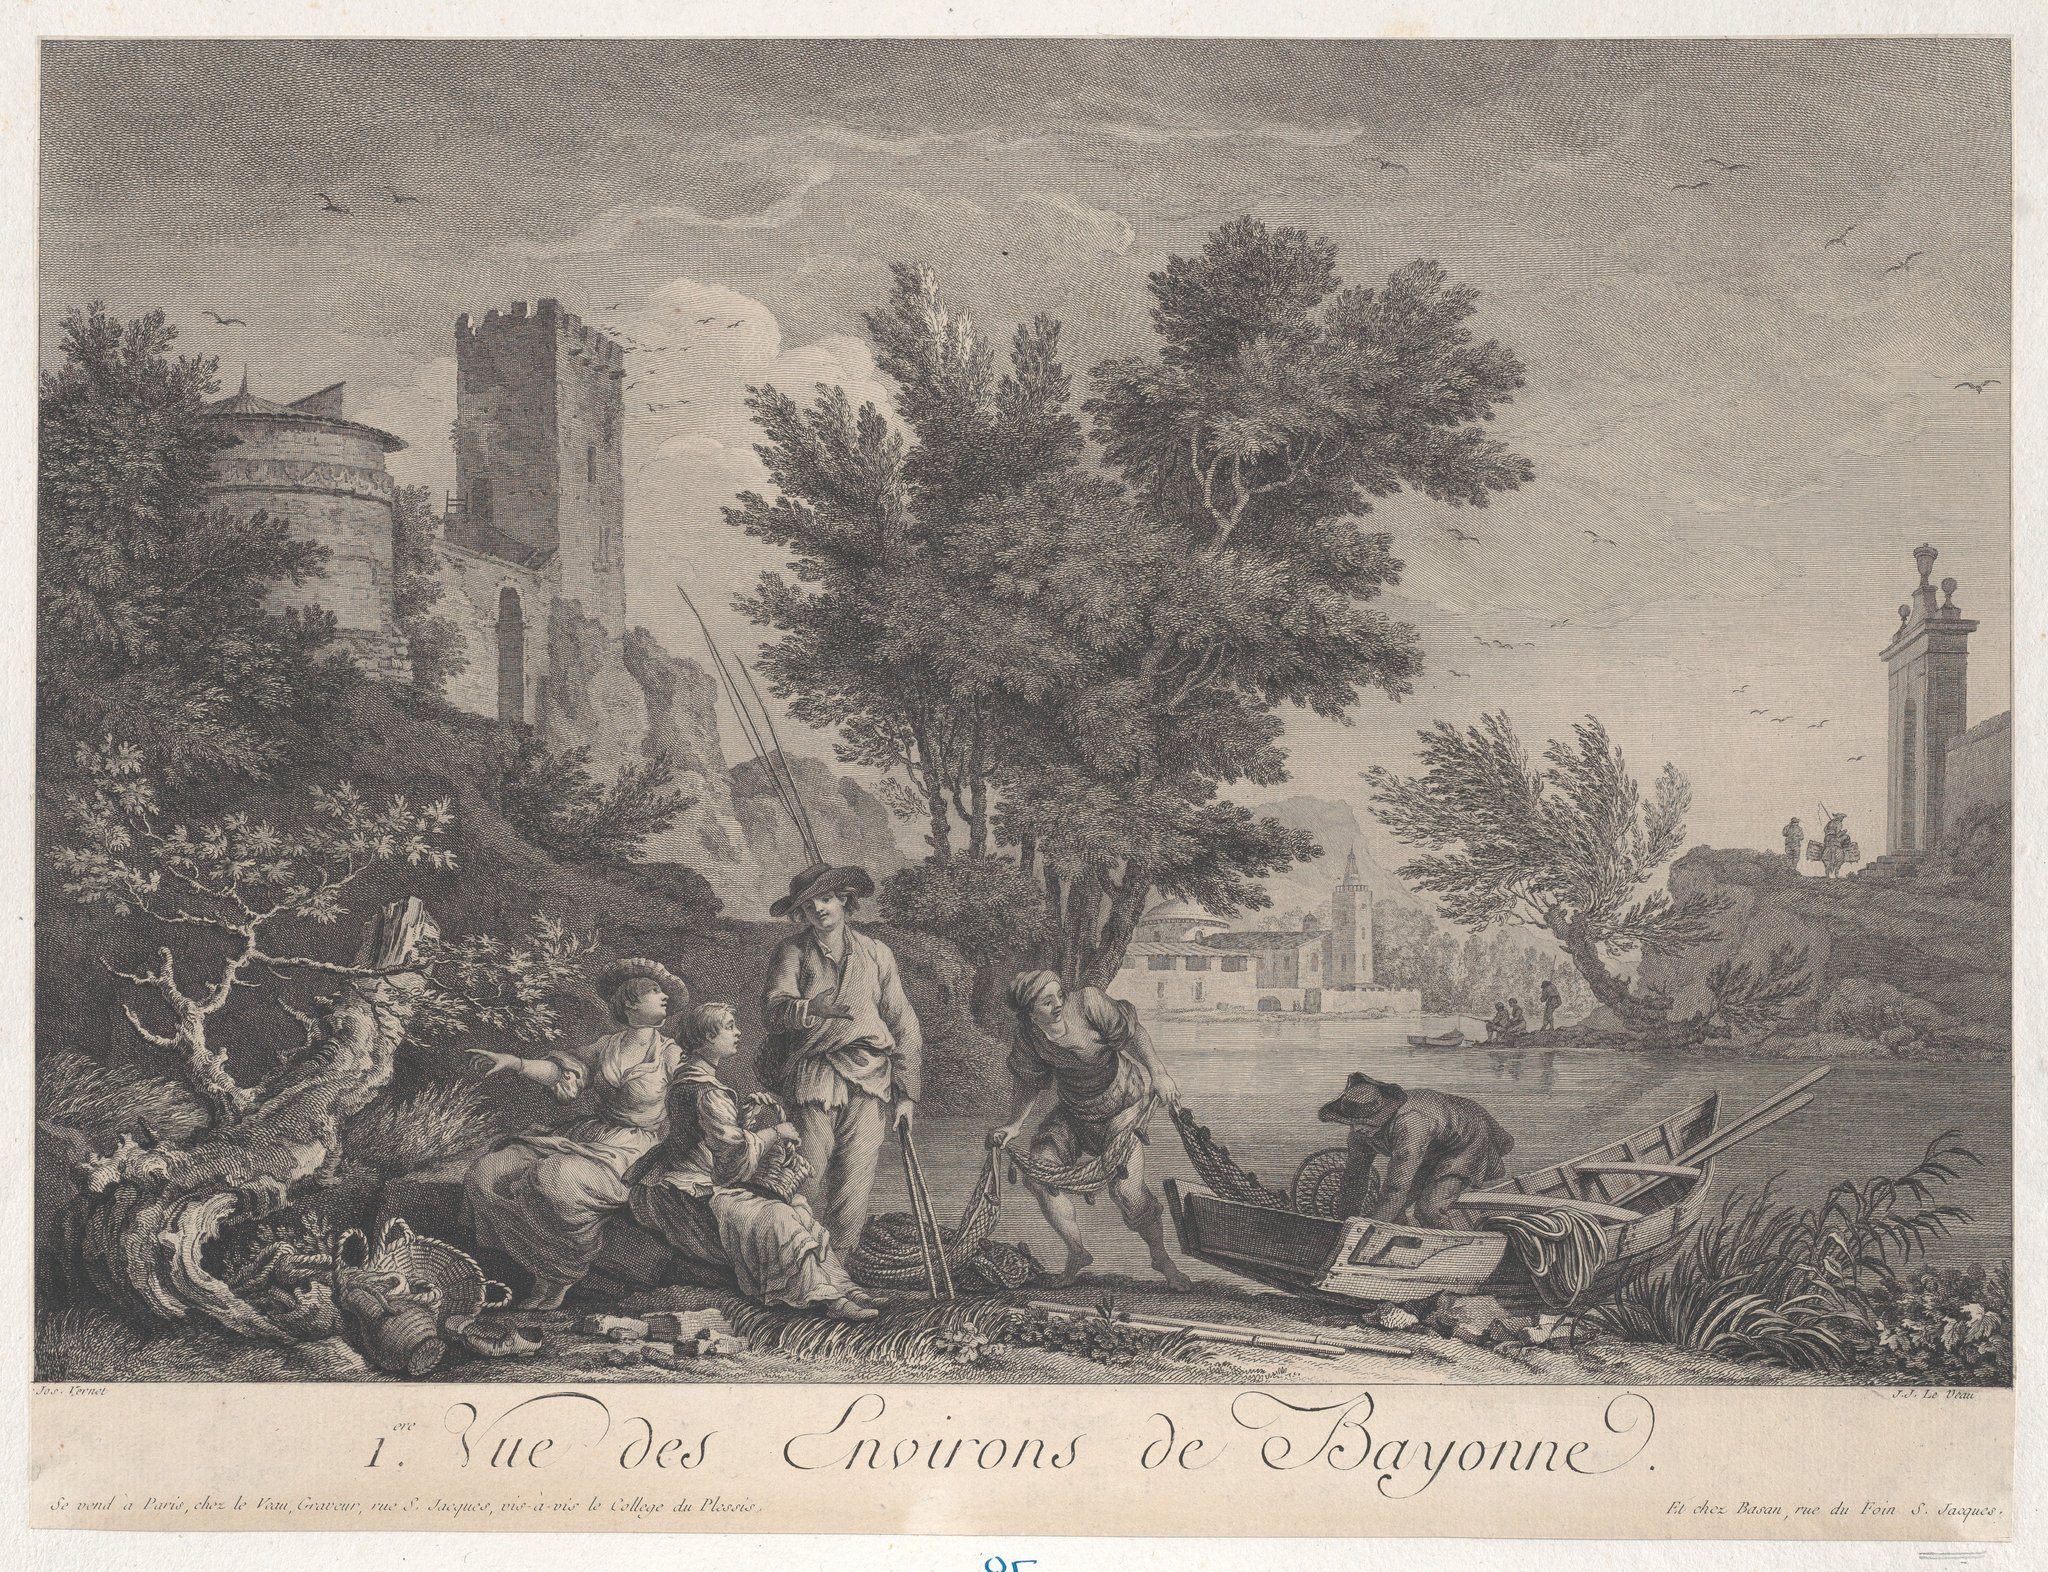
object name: print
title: First View of the Surroundings of Bayonne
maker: joseph vernet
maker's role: artist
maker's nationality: french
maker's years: 1714-1789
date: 1775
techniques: engraving